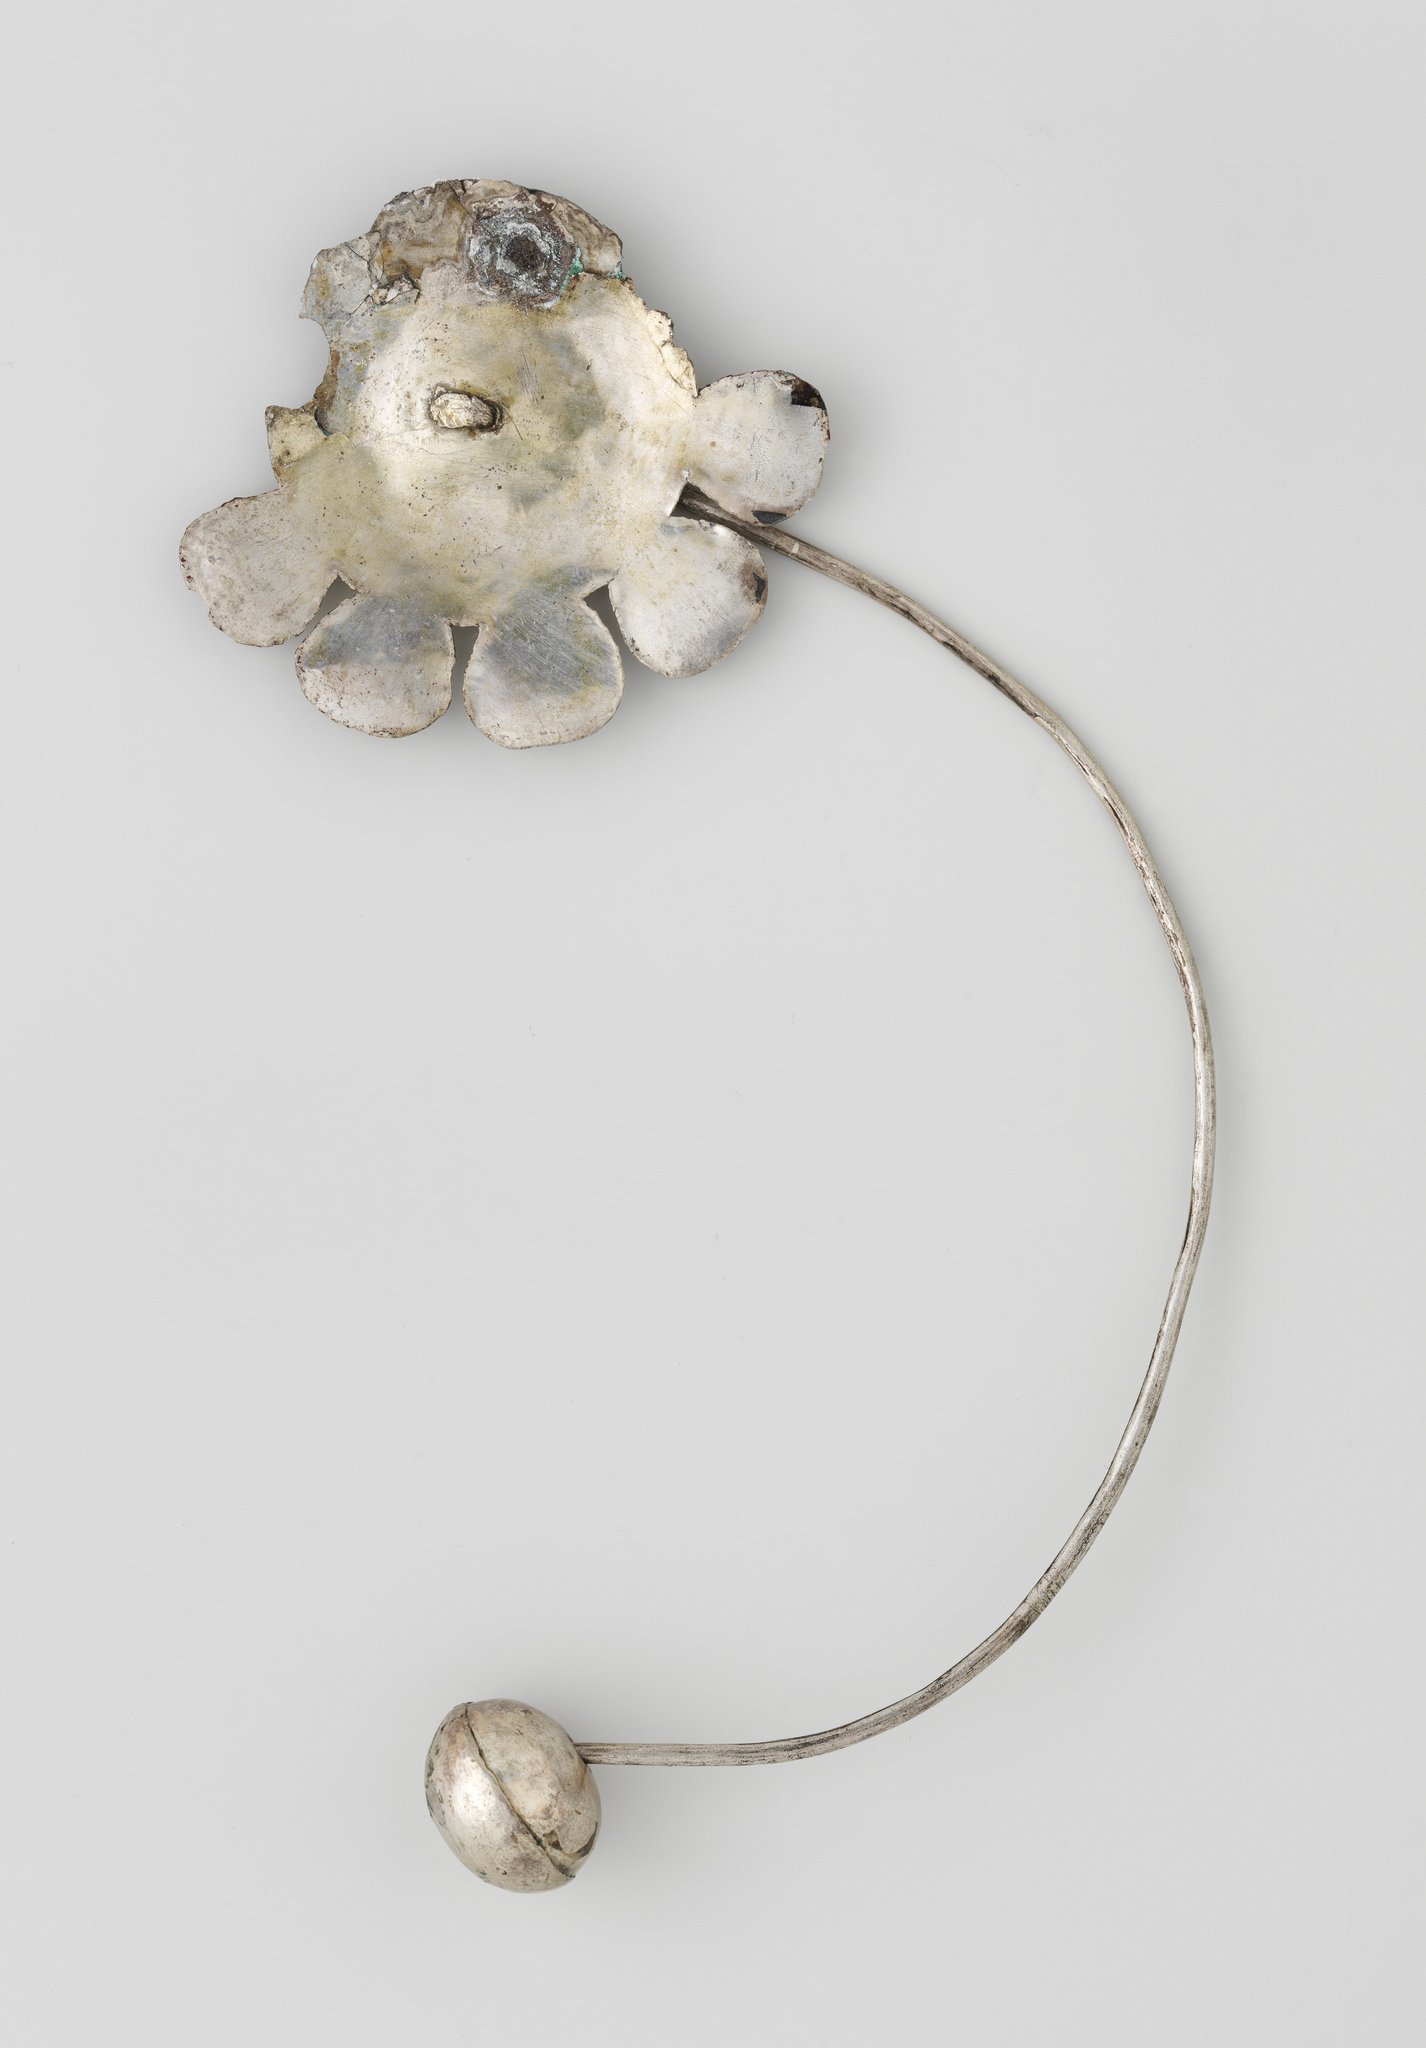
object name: ornament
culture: chancay or chimú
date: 1101-1500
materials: silver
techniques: hammering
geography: peru